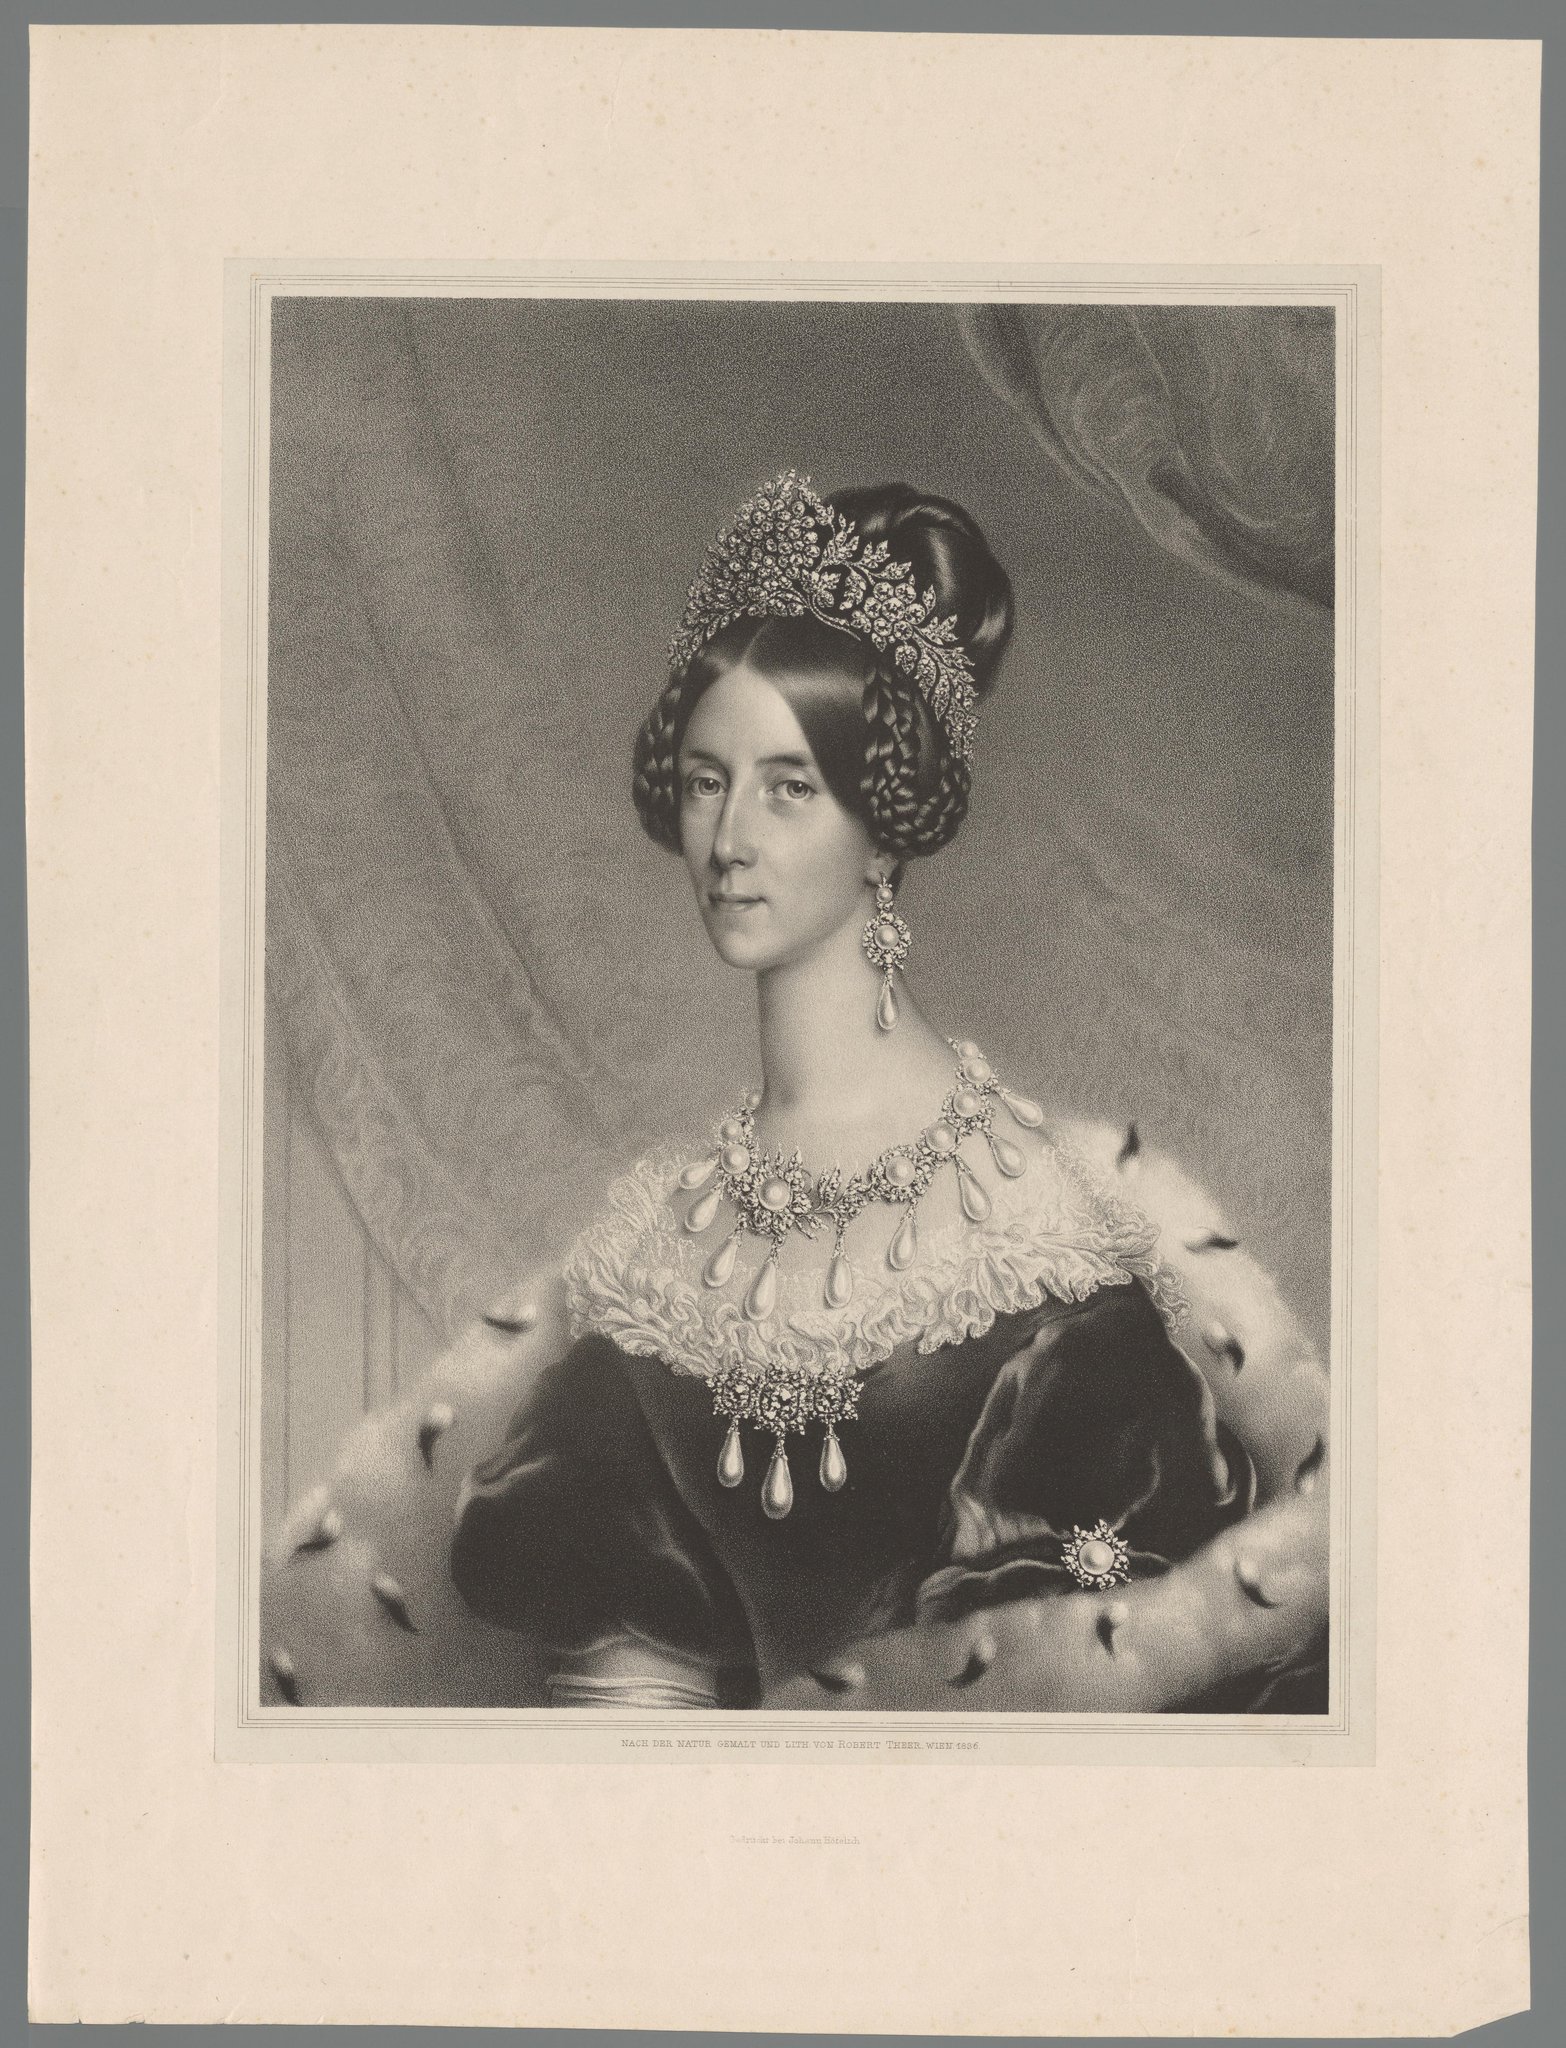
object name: print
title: Portret van een vrouw, mogelijk Maria Anna Carolina van Oostenrijk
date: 1836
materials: paper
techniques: lithograph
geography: vienna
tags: adult woman, historical persons, ornaments, jewels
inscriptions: collector's mark: Lugt 2228